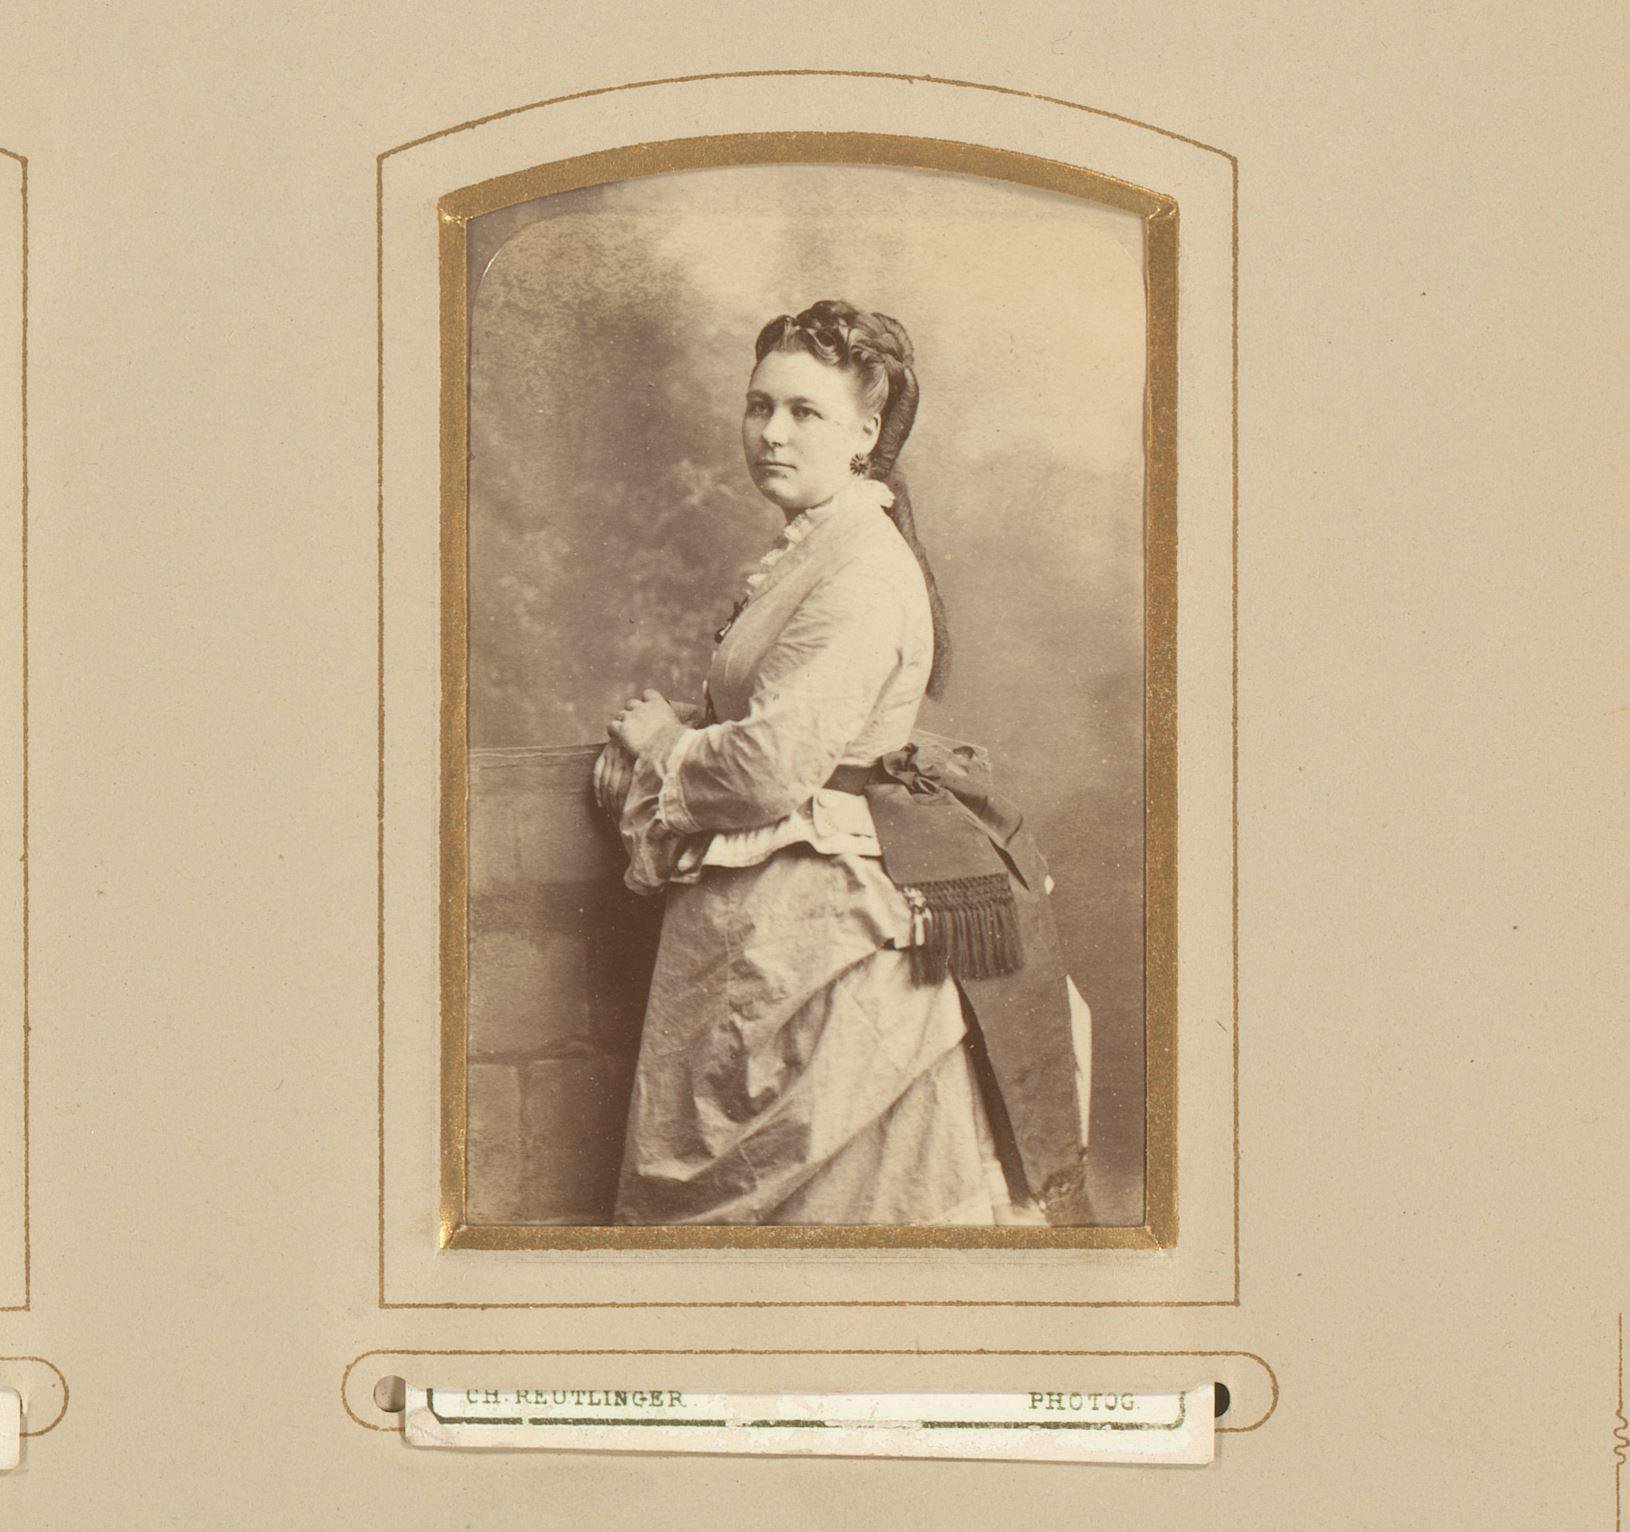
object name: photograph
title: Portret van een jonge vrouw bij een muur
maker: charles reutlinger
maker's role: publisher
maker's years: 1816-1880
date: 1868-1881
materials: cardboard, photographic support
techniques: albumen print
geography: paris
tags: historical persons - bb - woman, fence, wall, paling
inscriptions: inscription: ‘(...)/ PREMIER PRIX/ Exposition Universelle 1867/ CH. REUTLINGER/ PHOTOGRAPHE/ 21, Boulevard Montmartre, 21/ PARIS./ Les Clichés étant conservés, indéfiniment,/ on peut toujours se procurer de nouvelles/ épreuves de Cartes & Portraits sans reposer.’